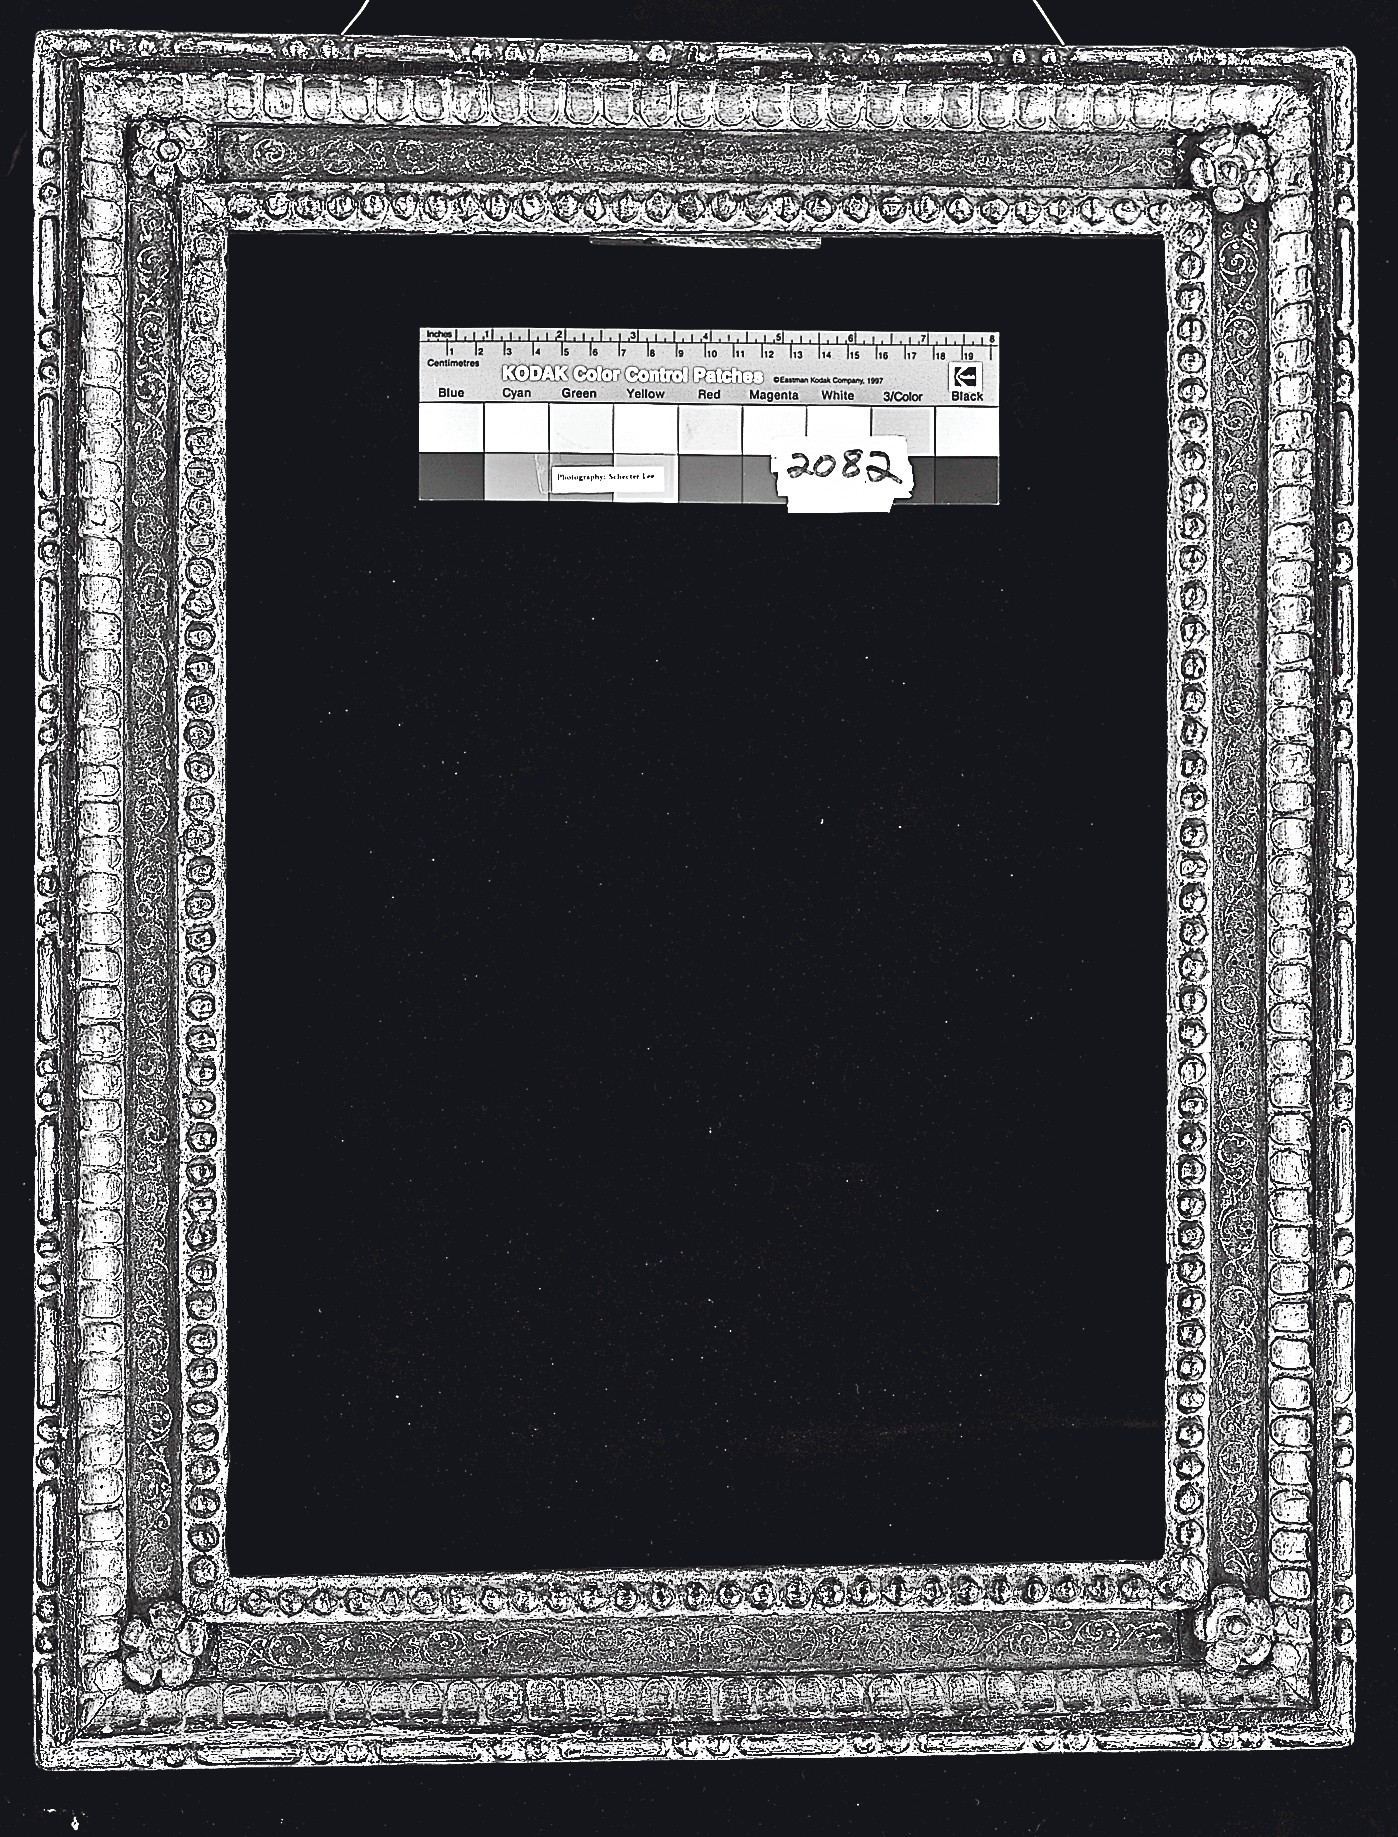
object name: frame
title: Cassetta frame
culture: italian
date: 1501-1533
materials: wood